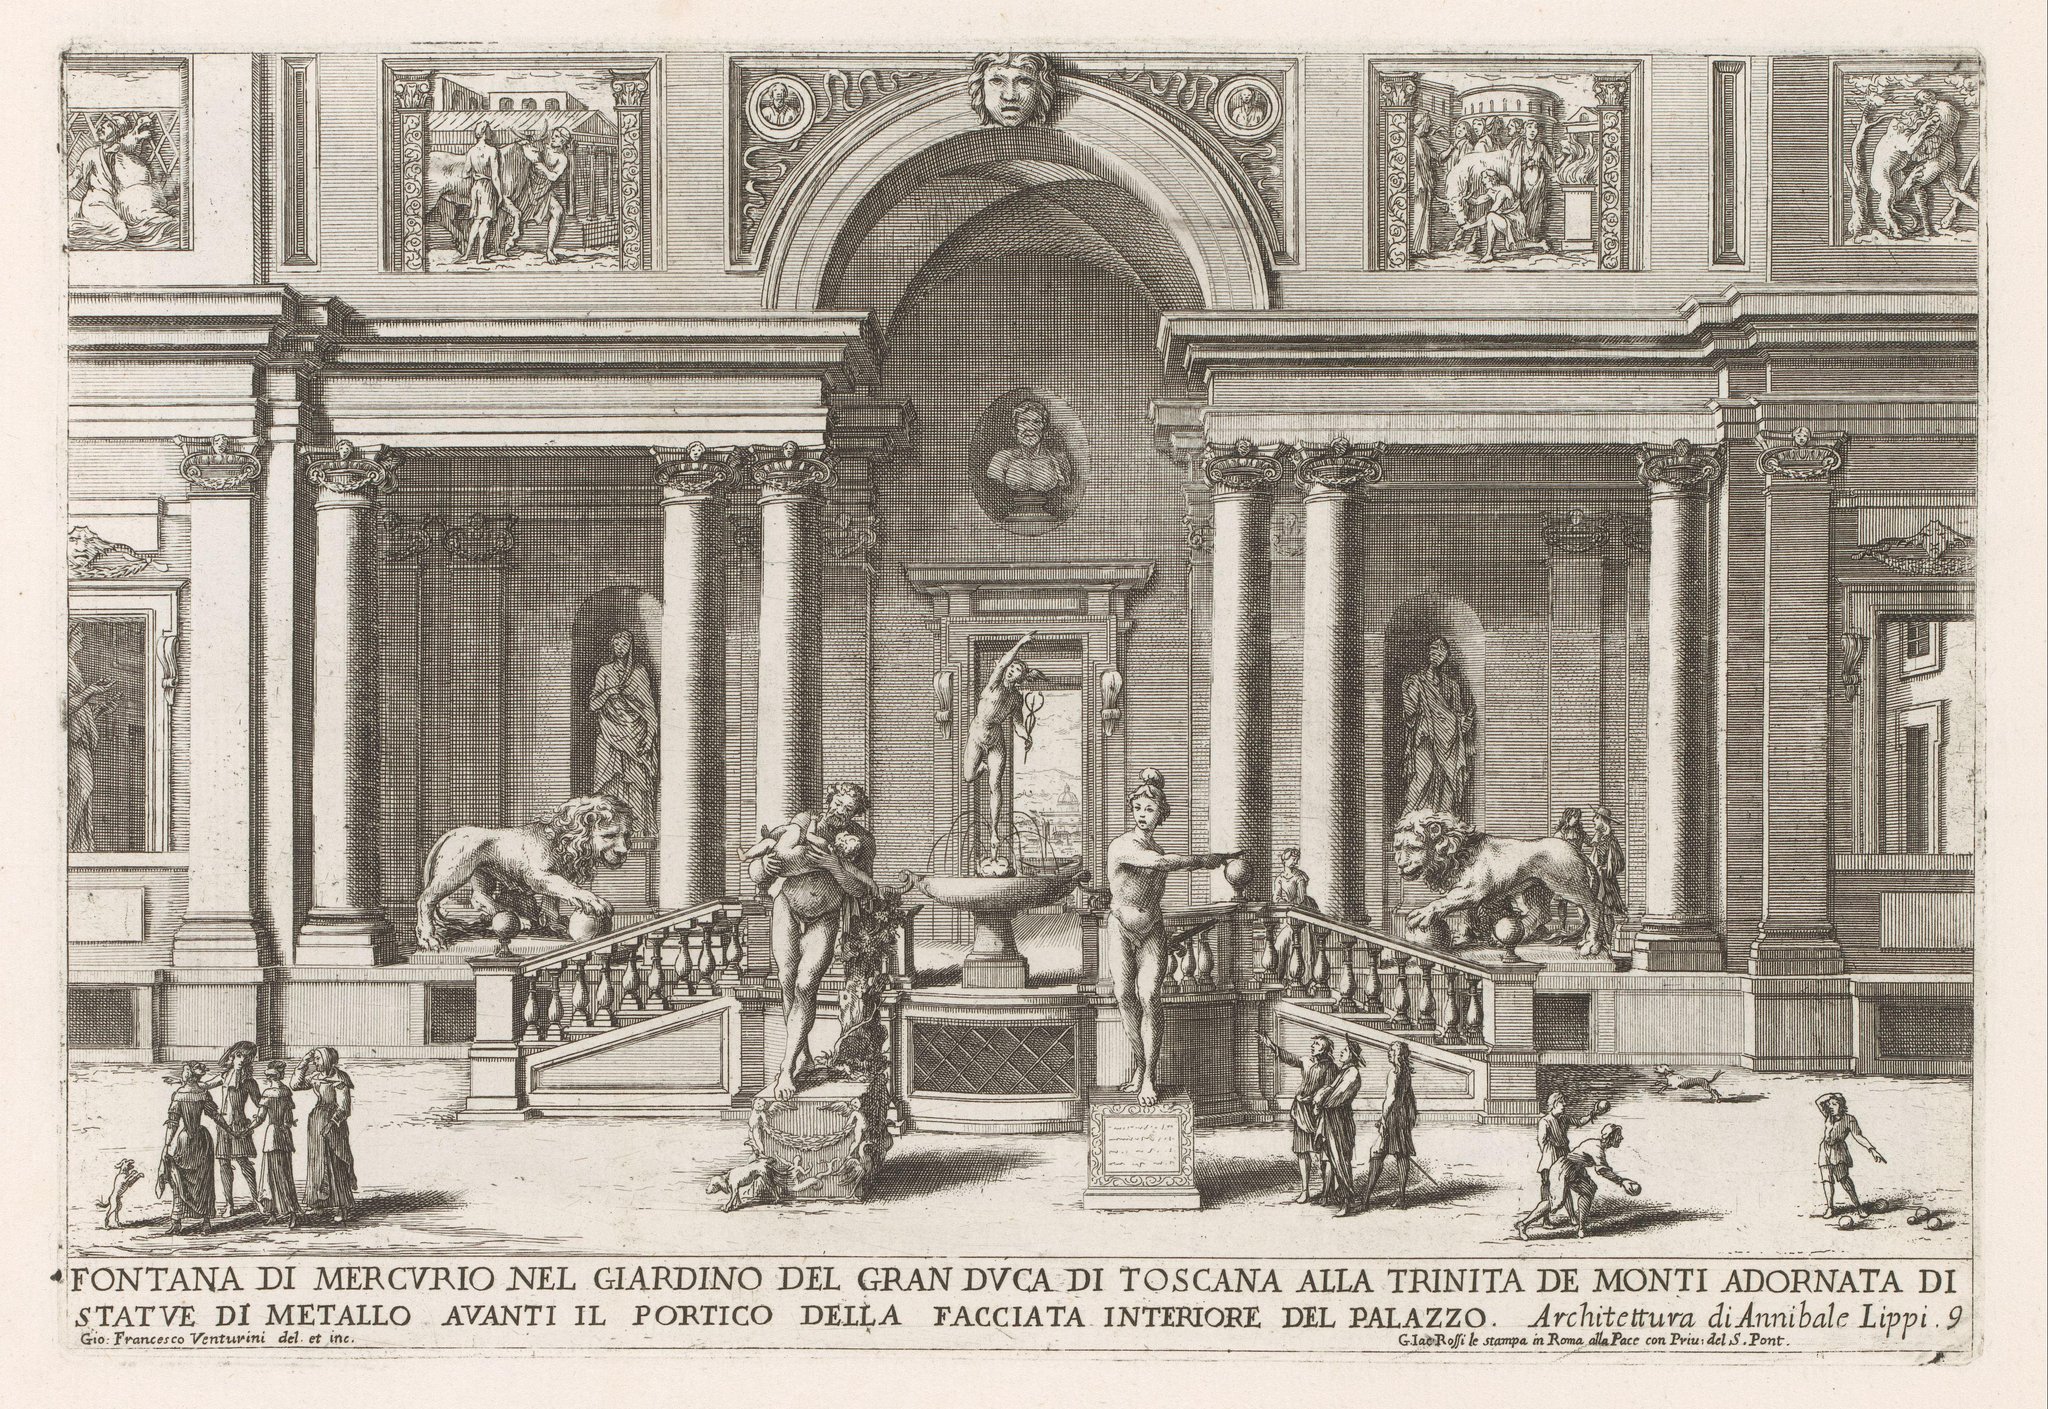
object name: print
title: Fonteinen in de paleizen en tuinen van Rome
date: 1653-1691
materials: paper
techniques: etching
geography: rome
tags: (story of) mercury (hermes), piece of sculpture, reproduction of a piece of sculpture, ornamental fountain, loggia, verandah, porch, rome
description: In de loggia een fontein met sculptuur van Mercurius door Giambologna en de twee Medici leeuwen. Op de voorgrond een sculptuur van Silenus met de jonge Bacchus en een sculptuur van Venus. Genummerd rechtsonder: 9. De prent maakt deel uit van een album.